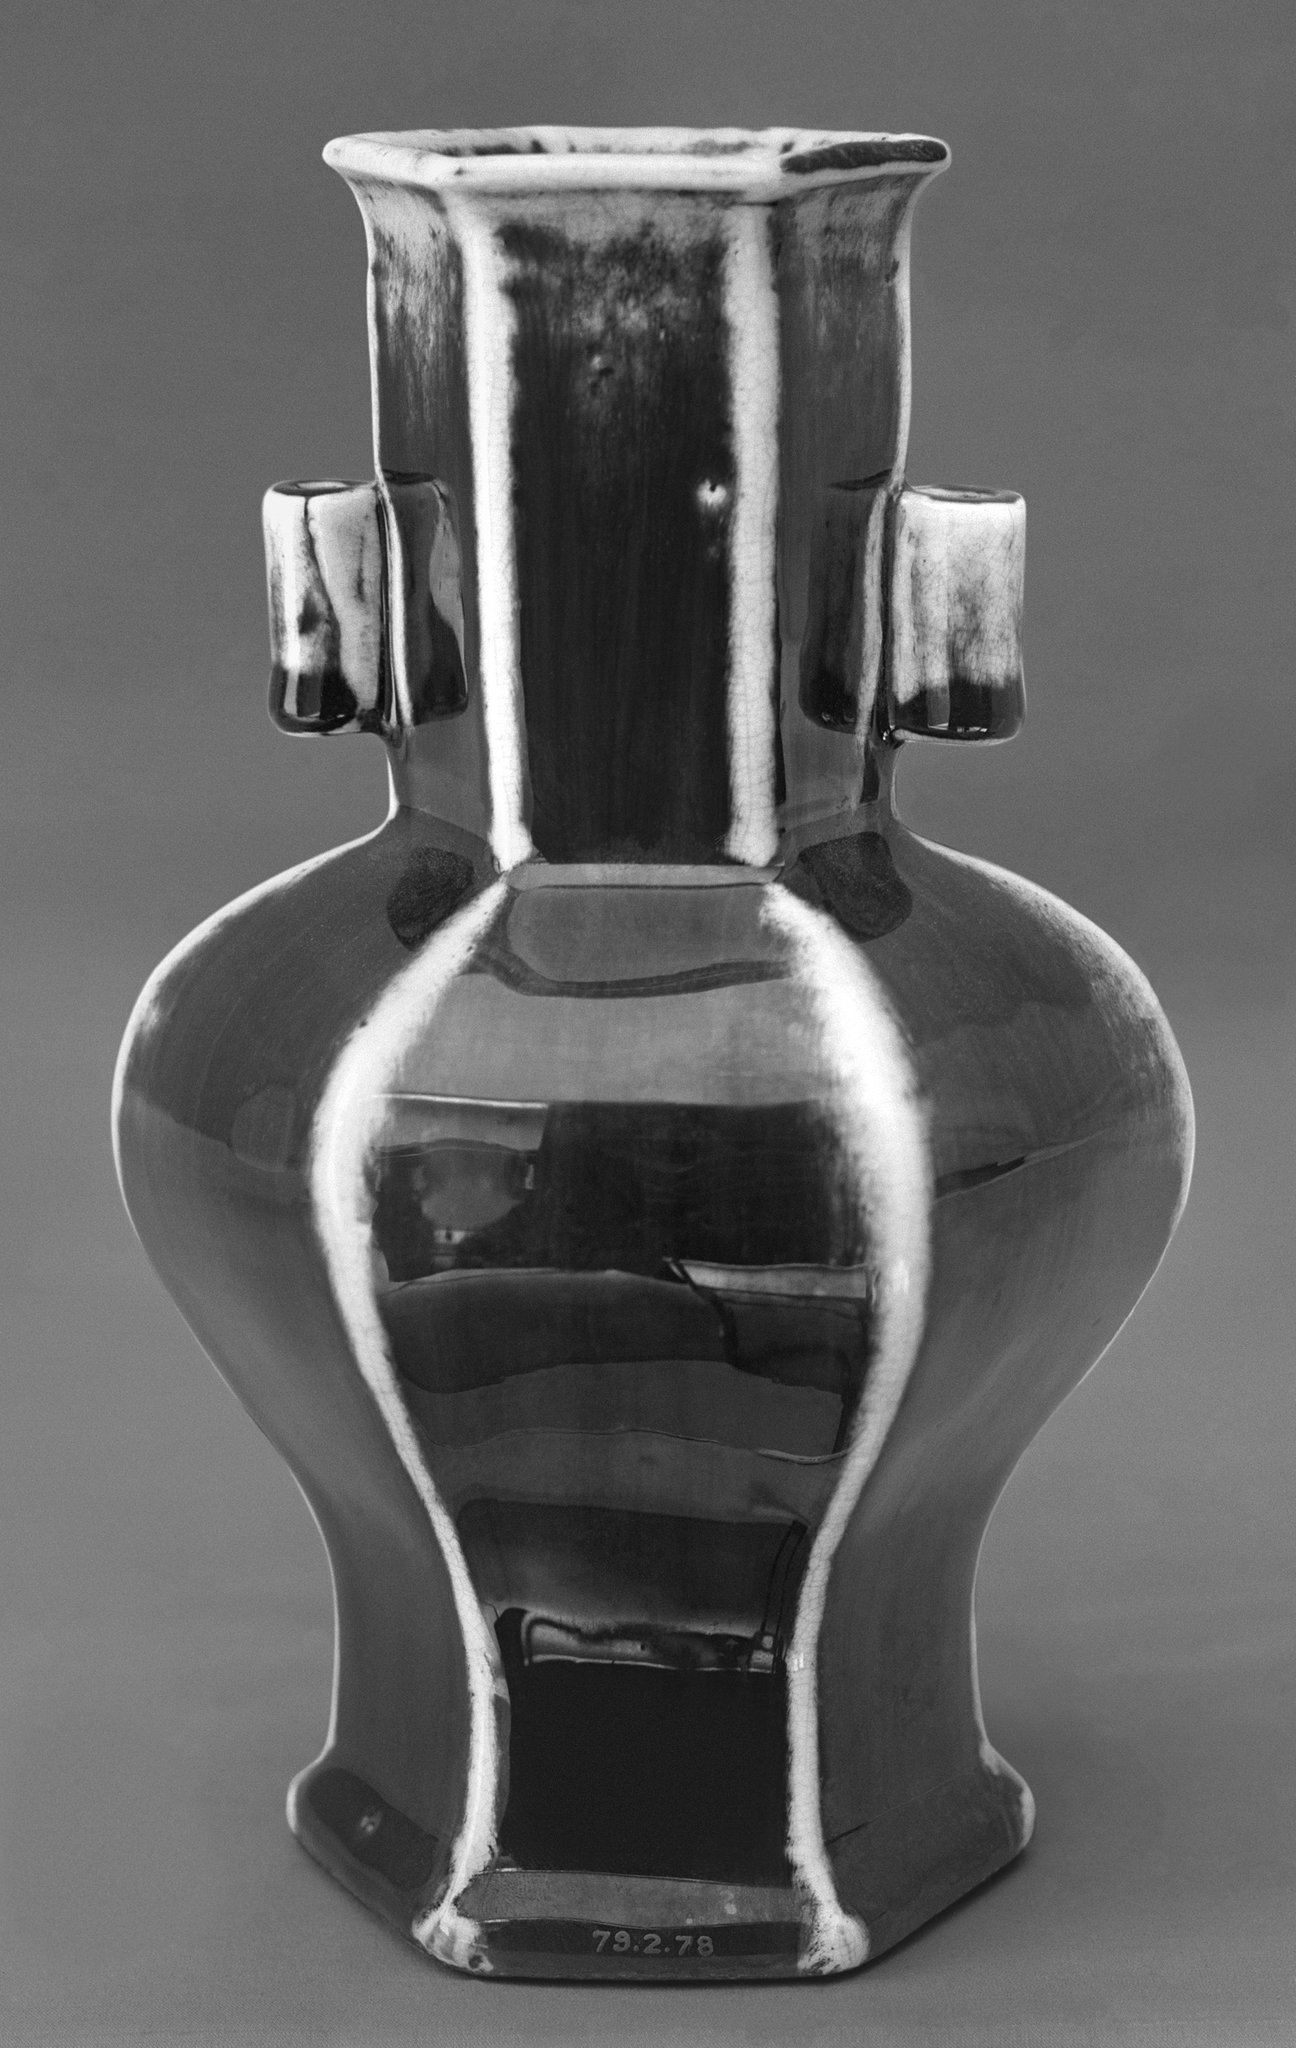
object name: vase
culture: chinese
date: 1801-1850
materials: glaze, porcelain